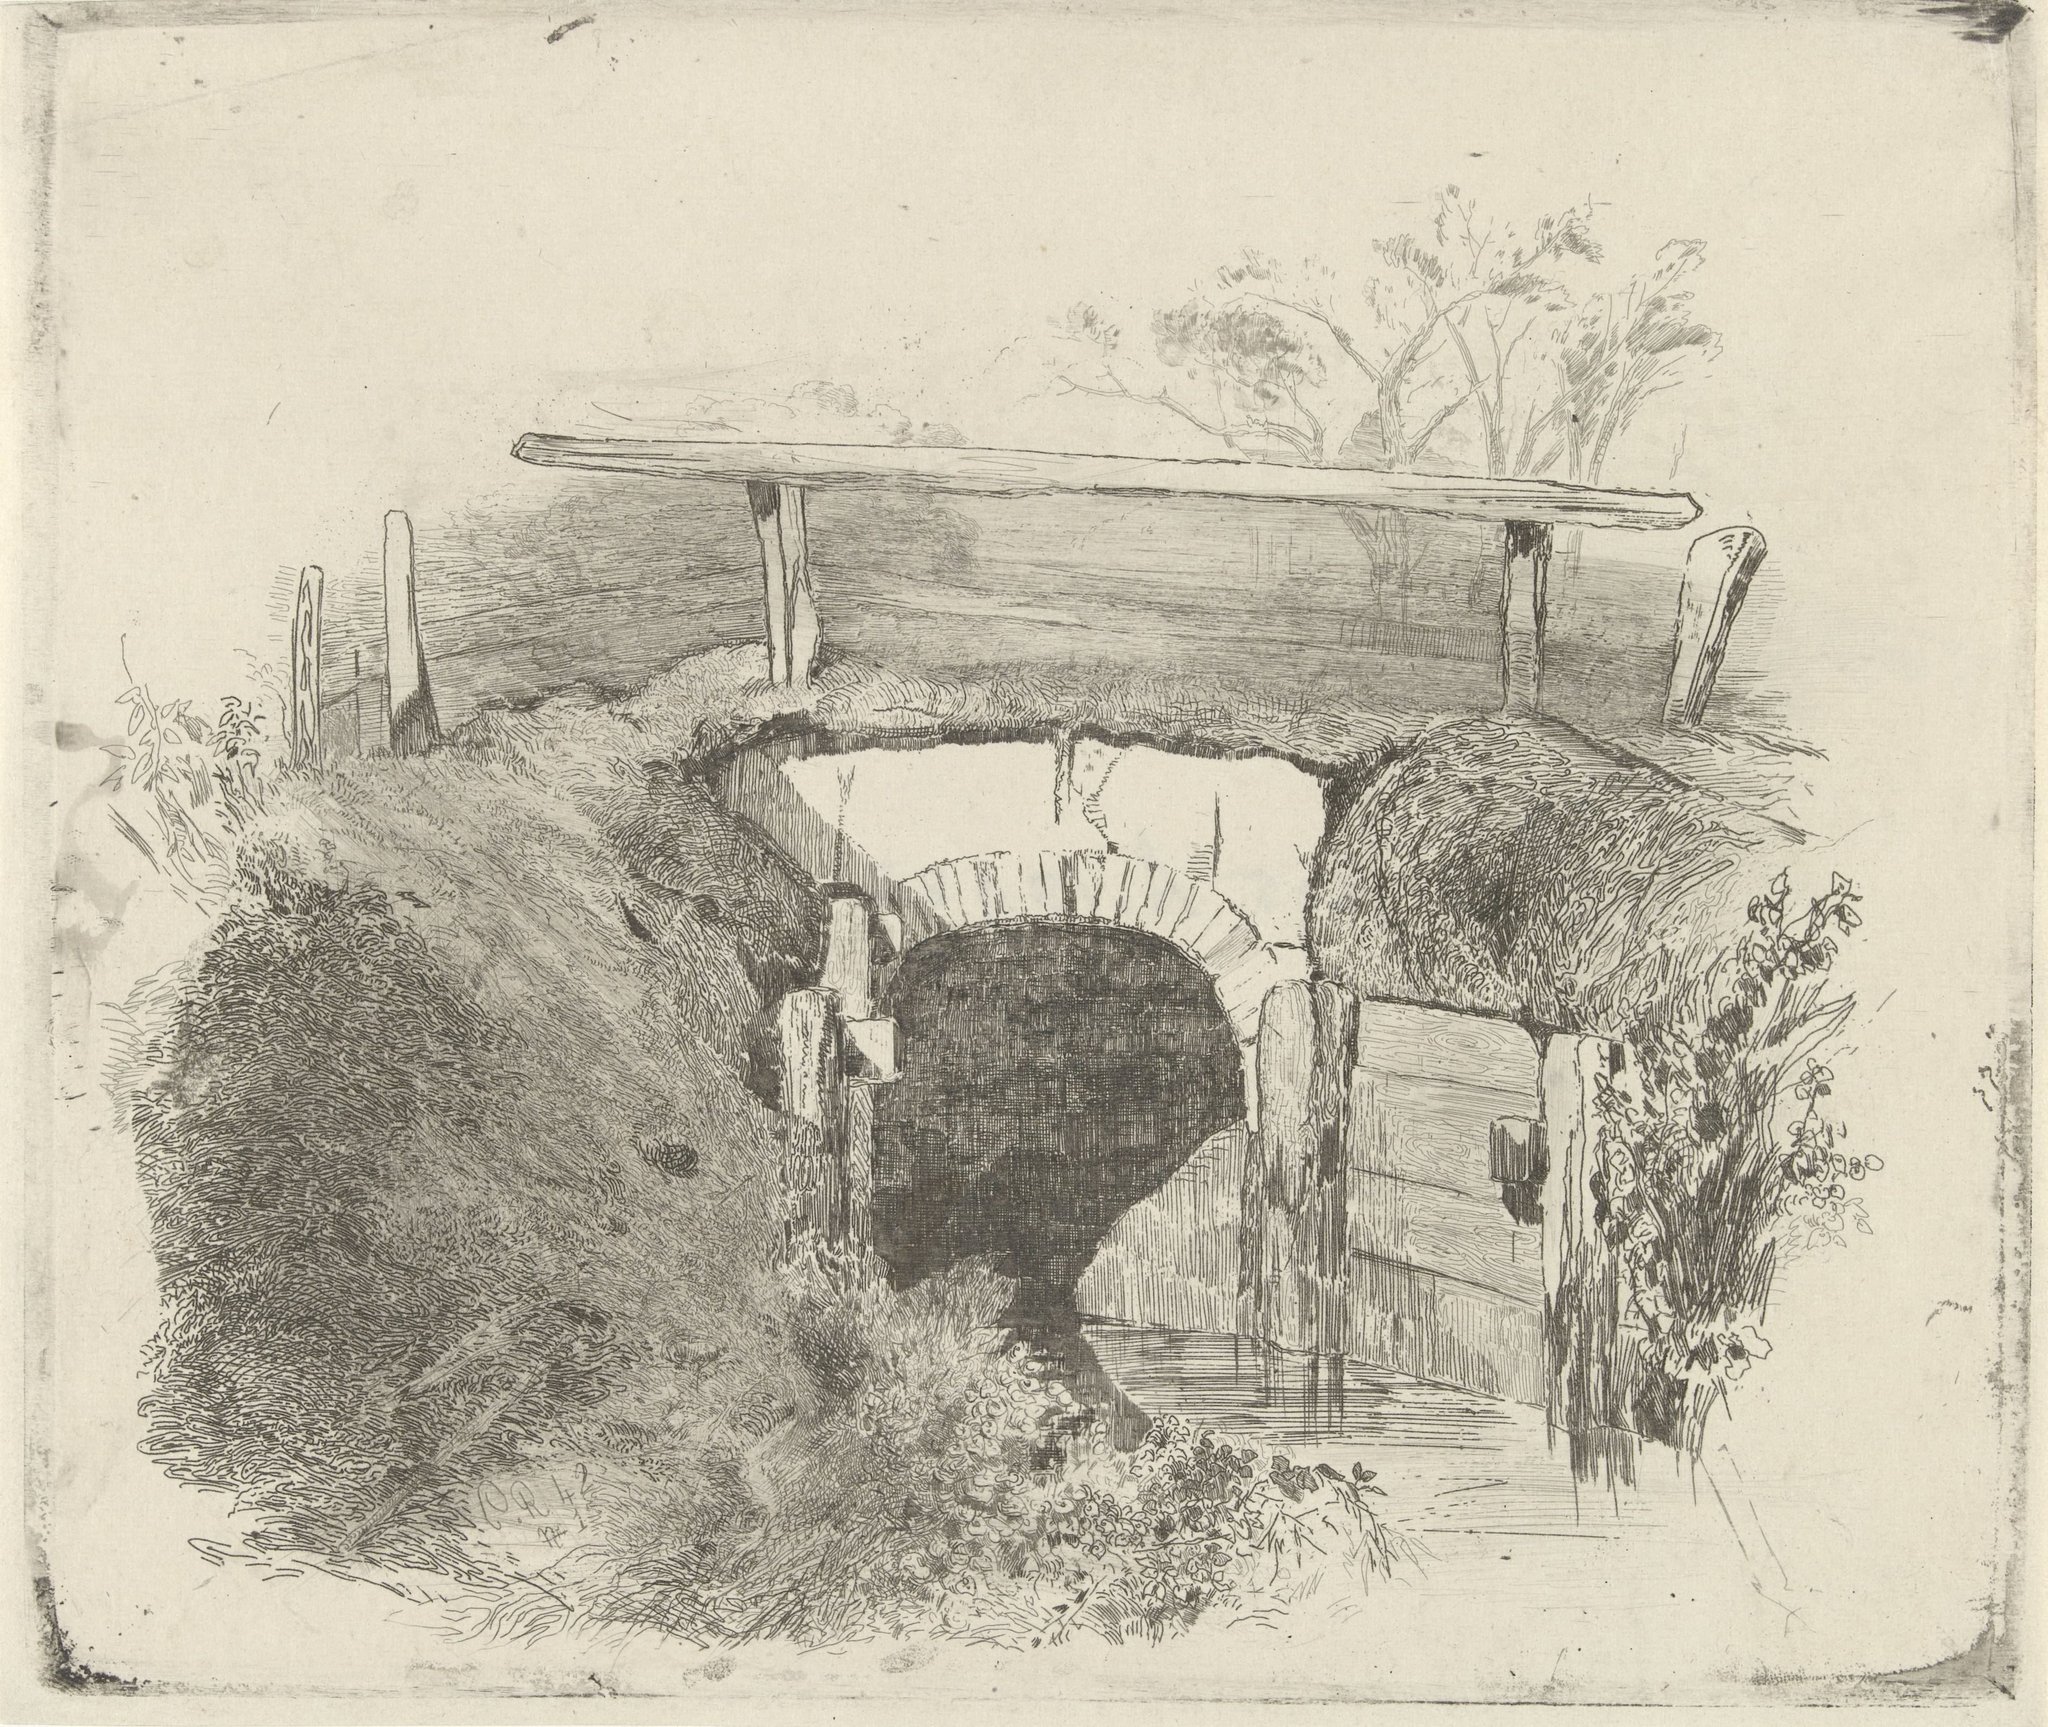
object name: print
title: Brug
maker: charles rochussen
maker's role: draughtsman, painter, print maker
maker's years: 1814-1894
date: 1842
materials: paper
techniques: drypoint, etching, intaglio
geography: the hague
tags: bridge, small canal, ditch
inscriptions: collector's mark: Lugt 2228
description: Gemetselde duikerbrug, met houten leuningen, over een sloot. Bij de sloot staan bloemen.